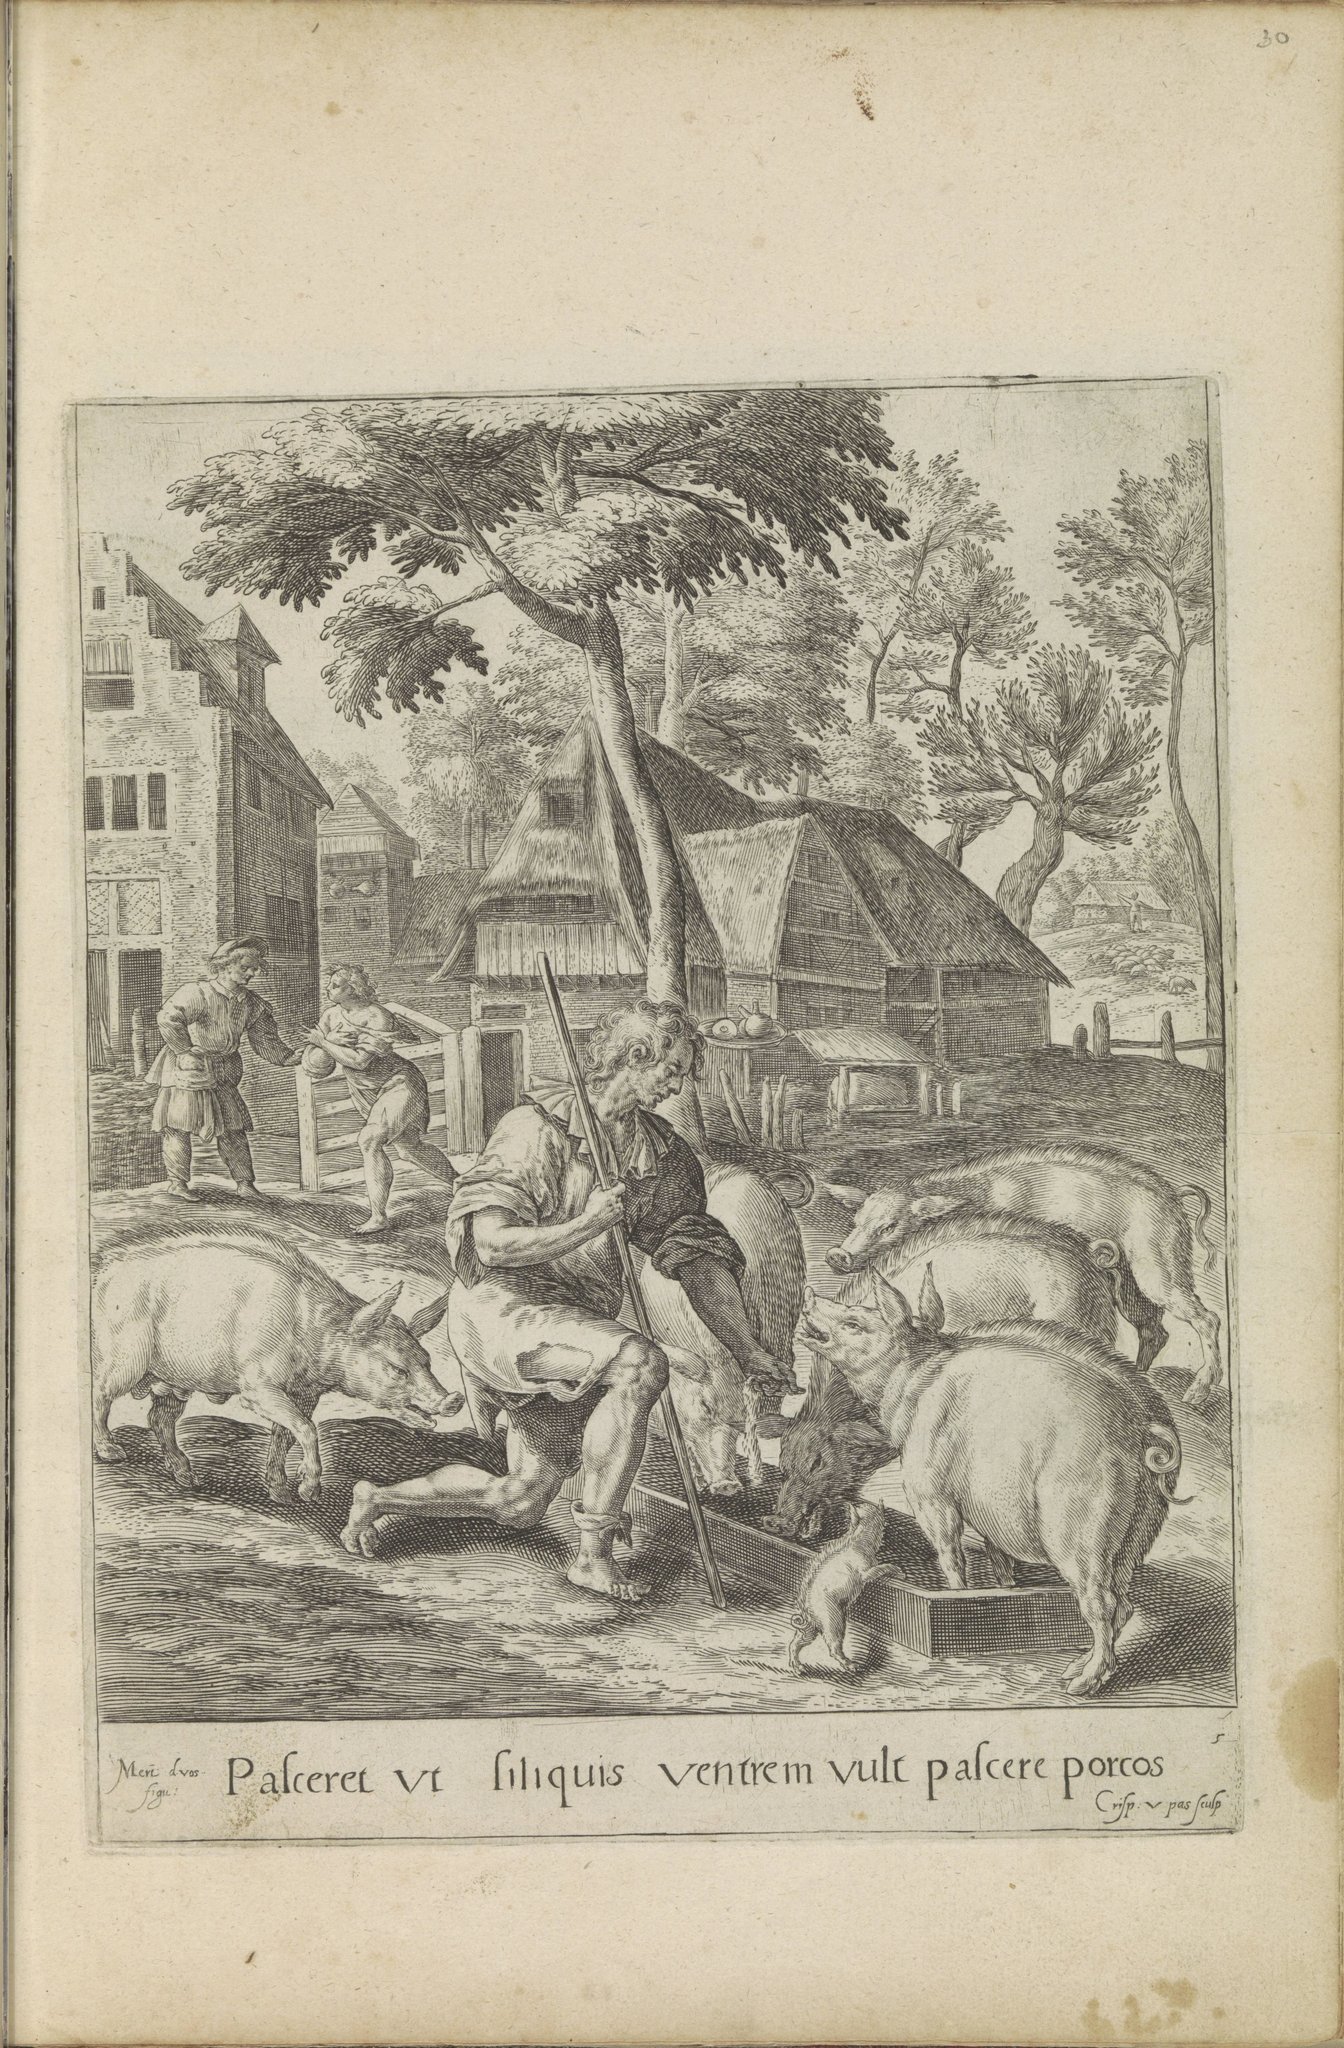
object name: print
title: Gelijkenis van de verloren zoon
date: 1580-1588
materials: paper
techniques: engraving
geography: antwerp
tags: the prodigal son tends the swine and eats from their trough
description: De verloren zoon als varkenshoeder. Hij heeft nauwelijks nog kleren en eet met de varkens uit de voederbak. Onder de voorstelling een verklarende tekst in het Latijn. Deze prent maakt deel uit van een album.